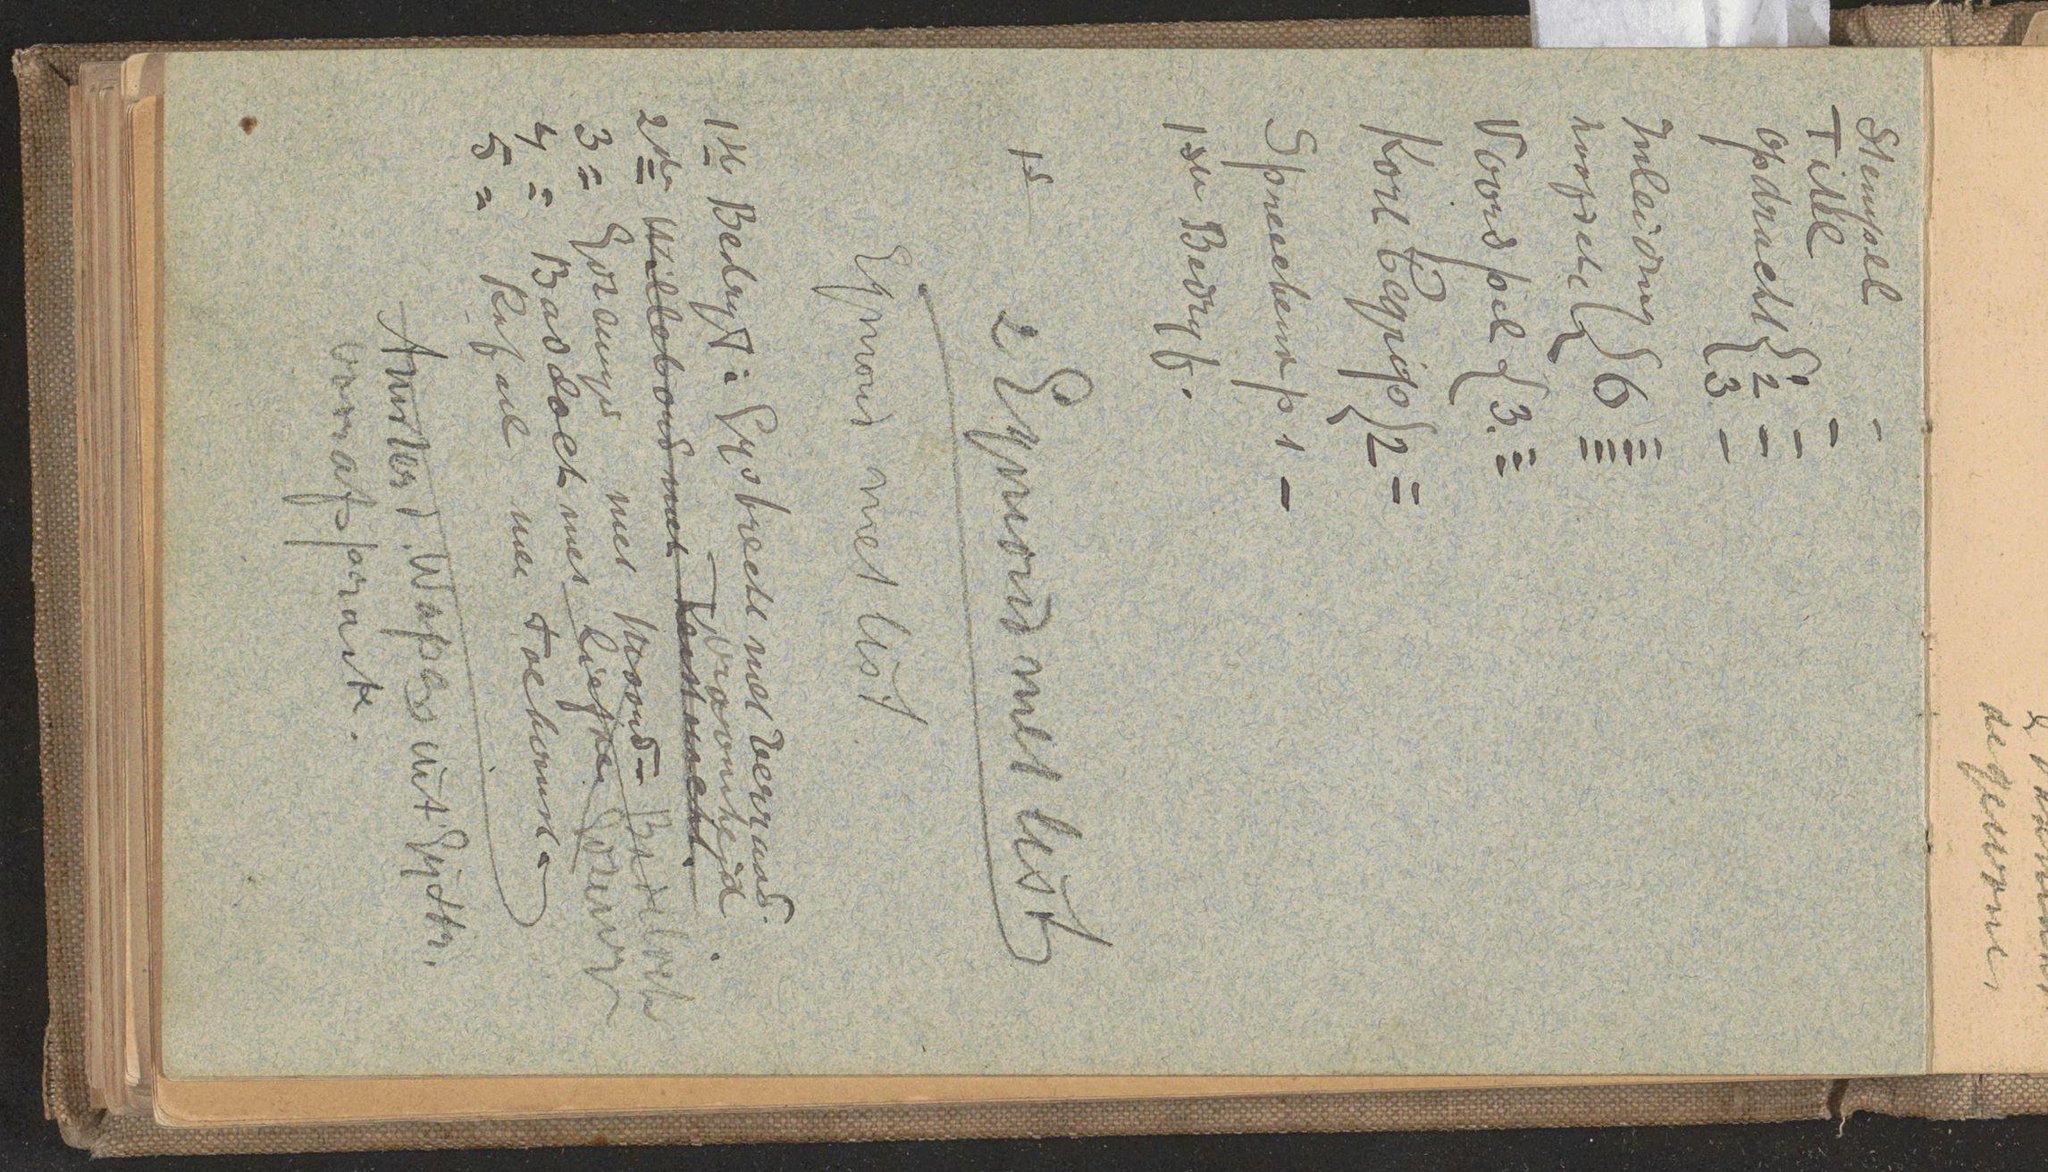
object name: sketchbook leaf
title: Notities over het boekontwerp voor 'Gijsbrecht van Aemstel' van Joost van den Vondel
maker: antoon derkinderen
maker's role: draughtsman, painter, print maker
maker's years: 1859-1925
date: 1893-1901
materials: ink, paper, pencil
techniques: pen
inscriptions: annotation: ‘Stempel/ Ti[...]/ opdracht{1/ 2/ 3/ Inleiding/ hoofd etc} 6/ Voorspel {3/ [...]/ 1ste Bedrijf: Gijsbrecht met verraad.’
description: Blad 46 verso uit een schetsboek met 51 bladen.